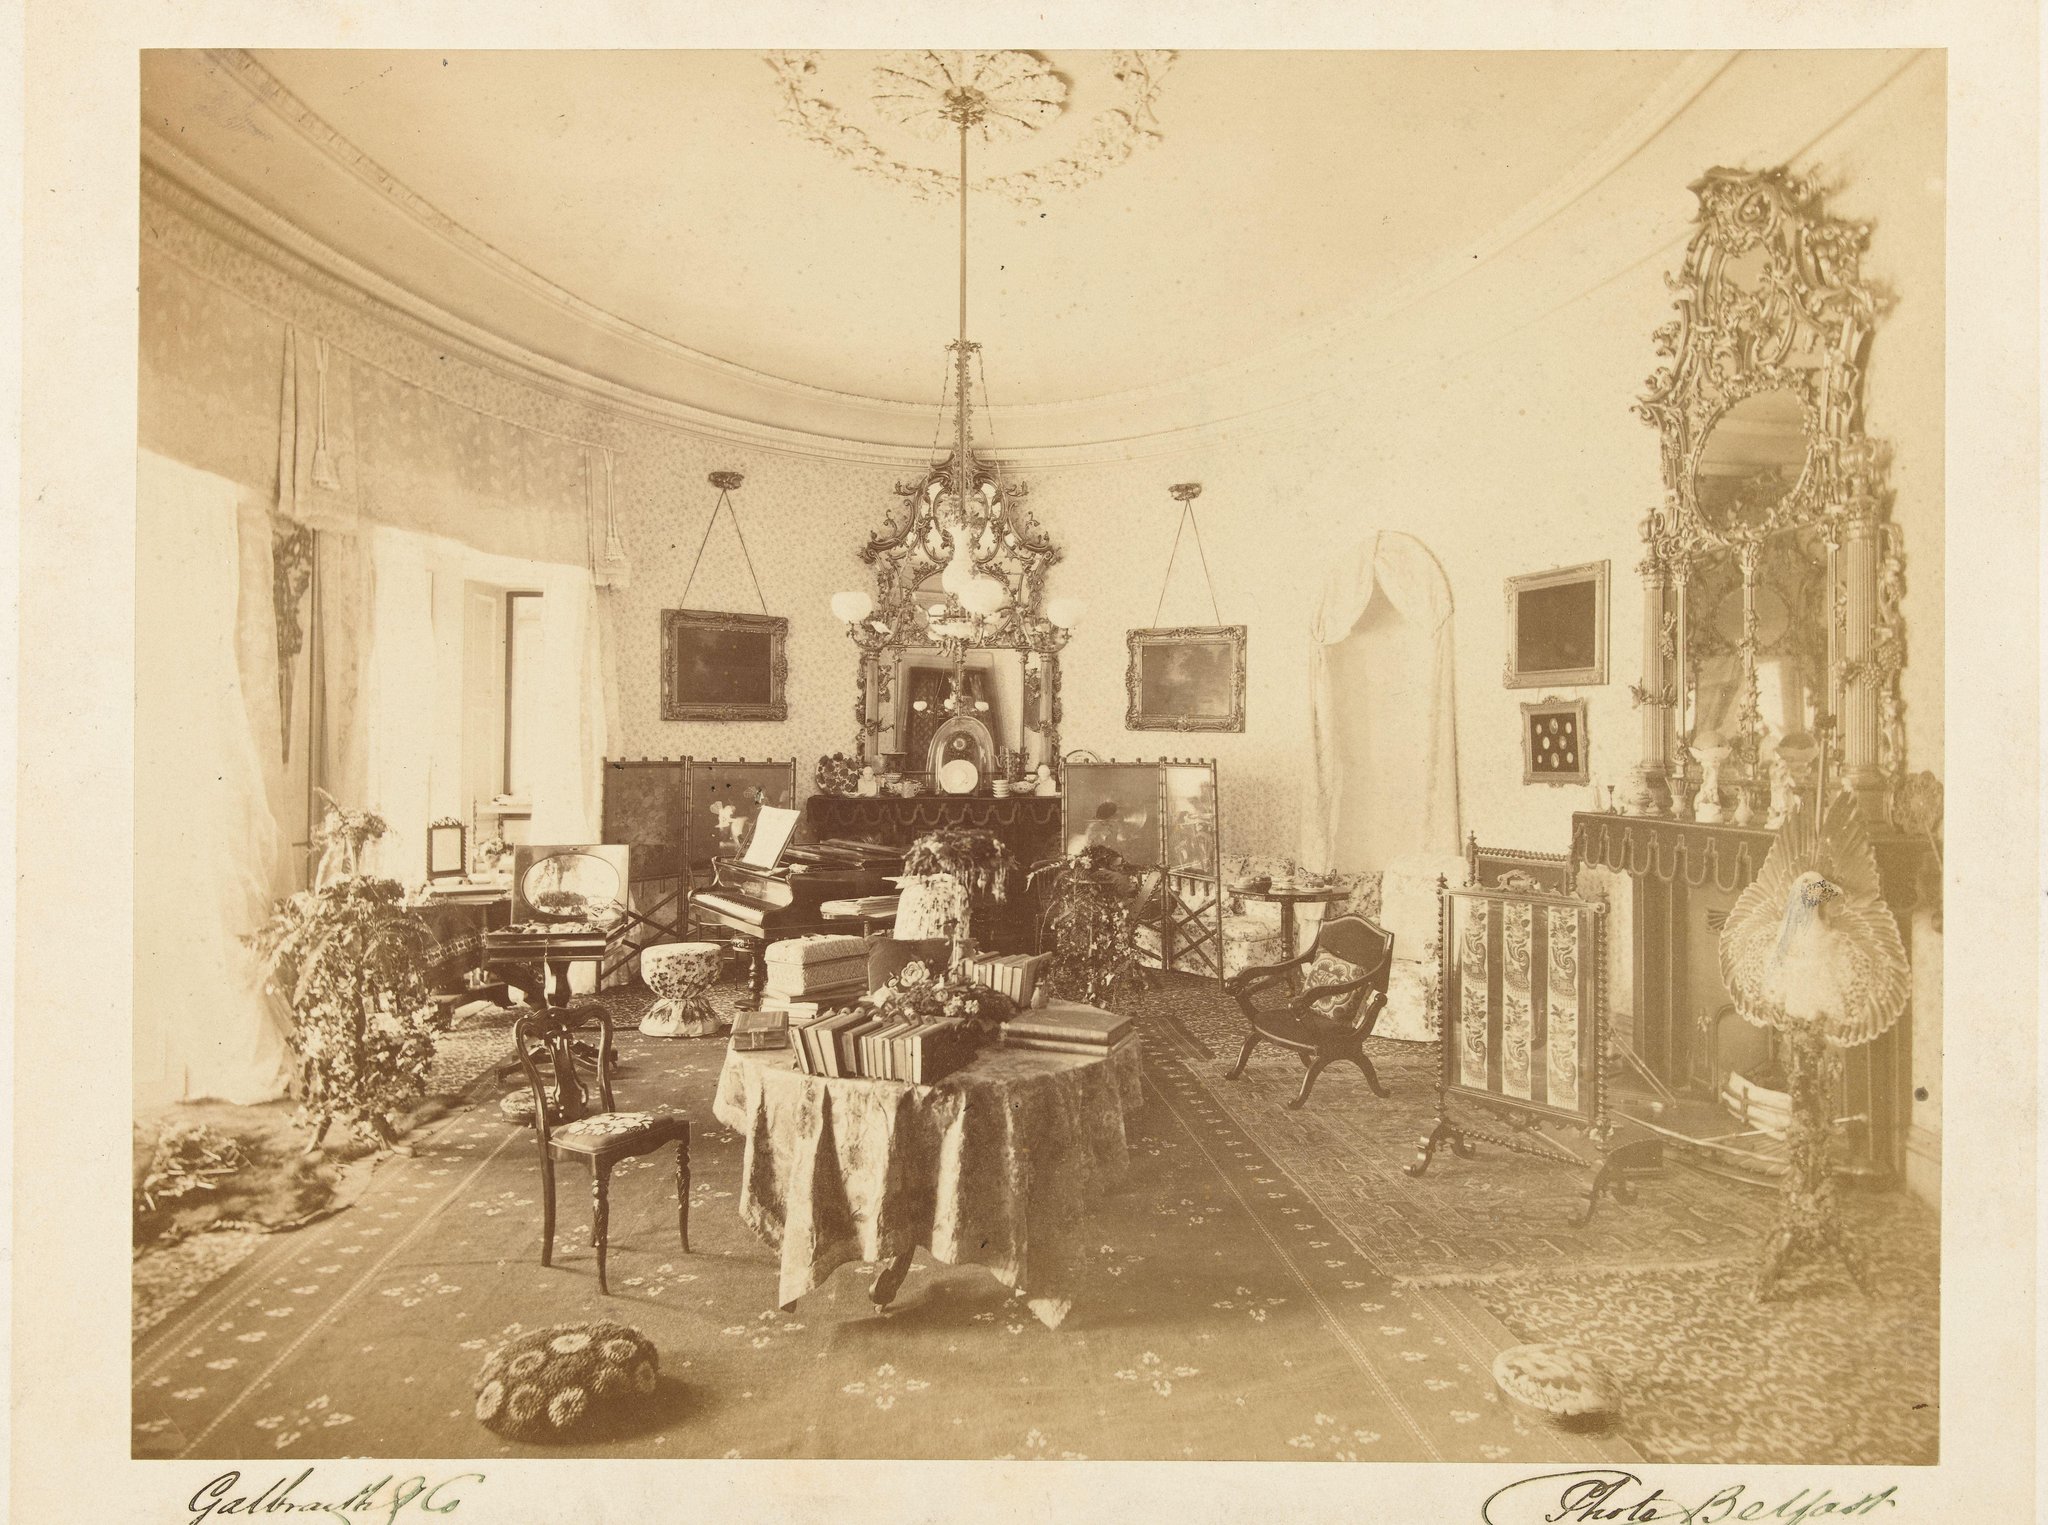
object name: photograph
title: Interieur van een salon, mogelijk in Belfast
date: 1880-1900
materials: cardboard, paper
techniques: albumen print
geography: belfast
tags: boudoir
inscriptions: inscription: ‘Photo Belfast’, : ‘gekocht Londen (fa R[...]) maart 1993 f4. 4357’